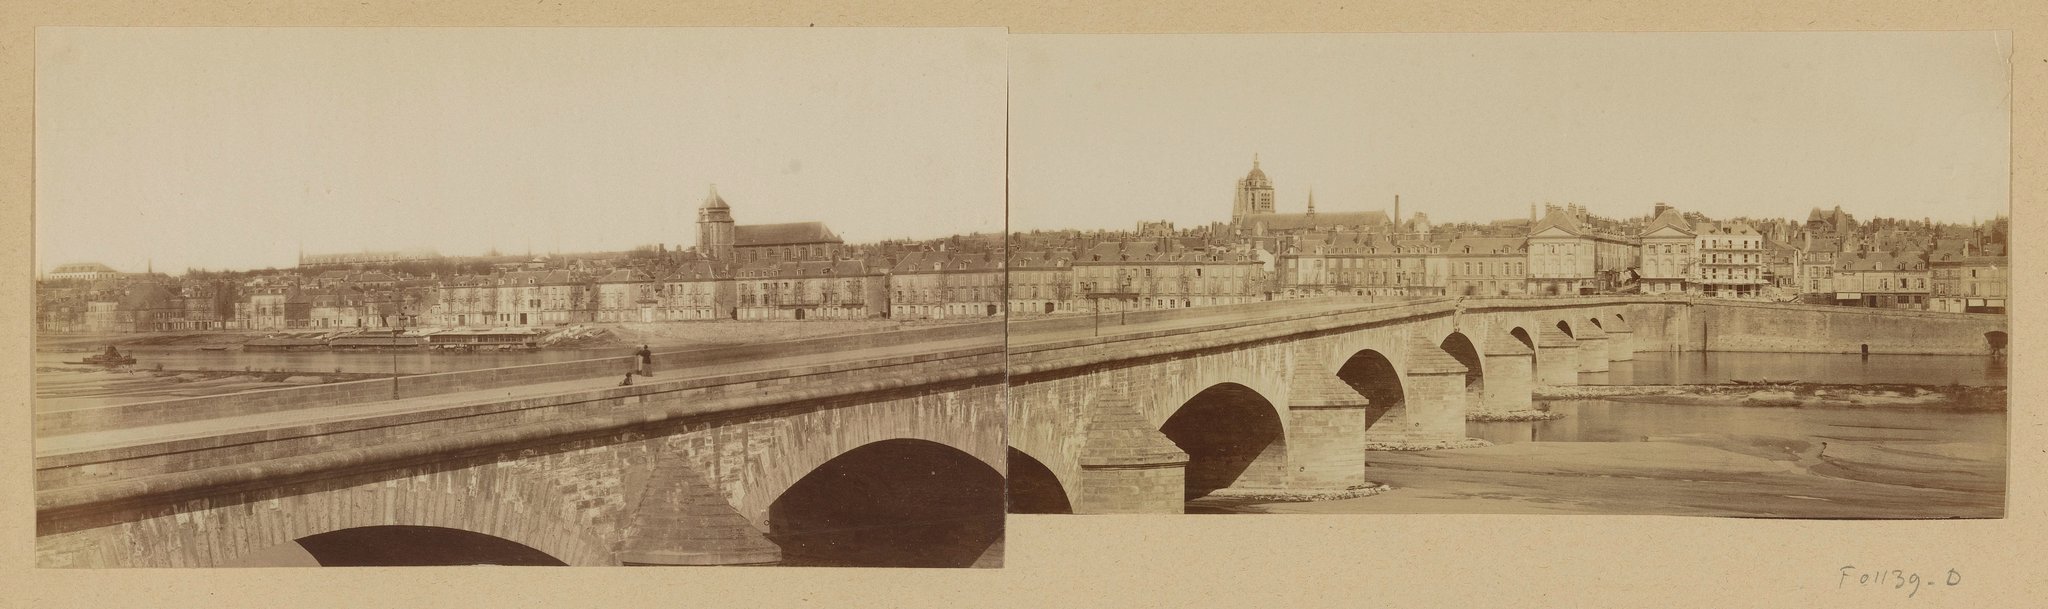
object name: panoramic photograph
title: Gezicht op Orléans, op de voorgrond de Pont George-V over de Loire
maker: Anonymous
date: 1851-1890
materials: paper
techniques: albumen print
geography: orléans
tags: bridge in city across river, canal, etc.